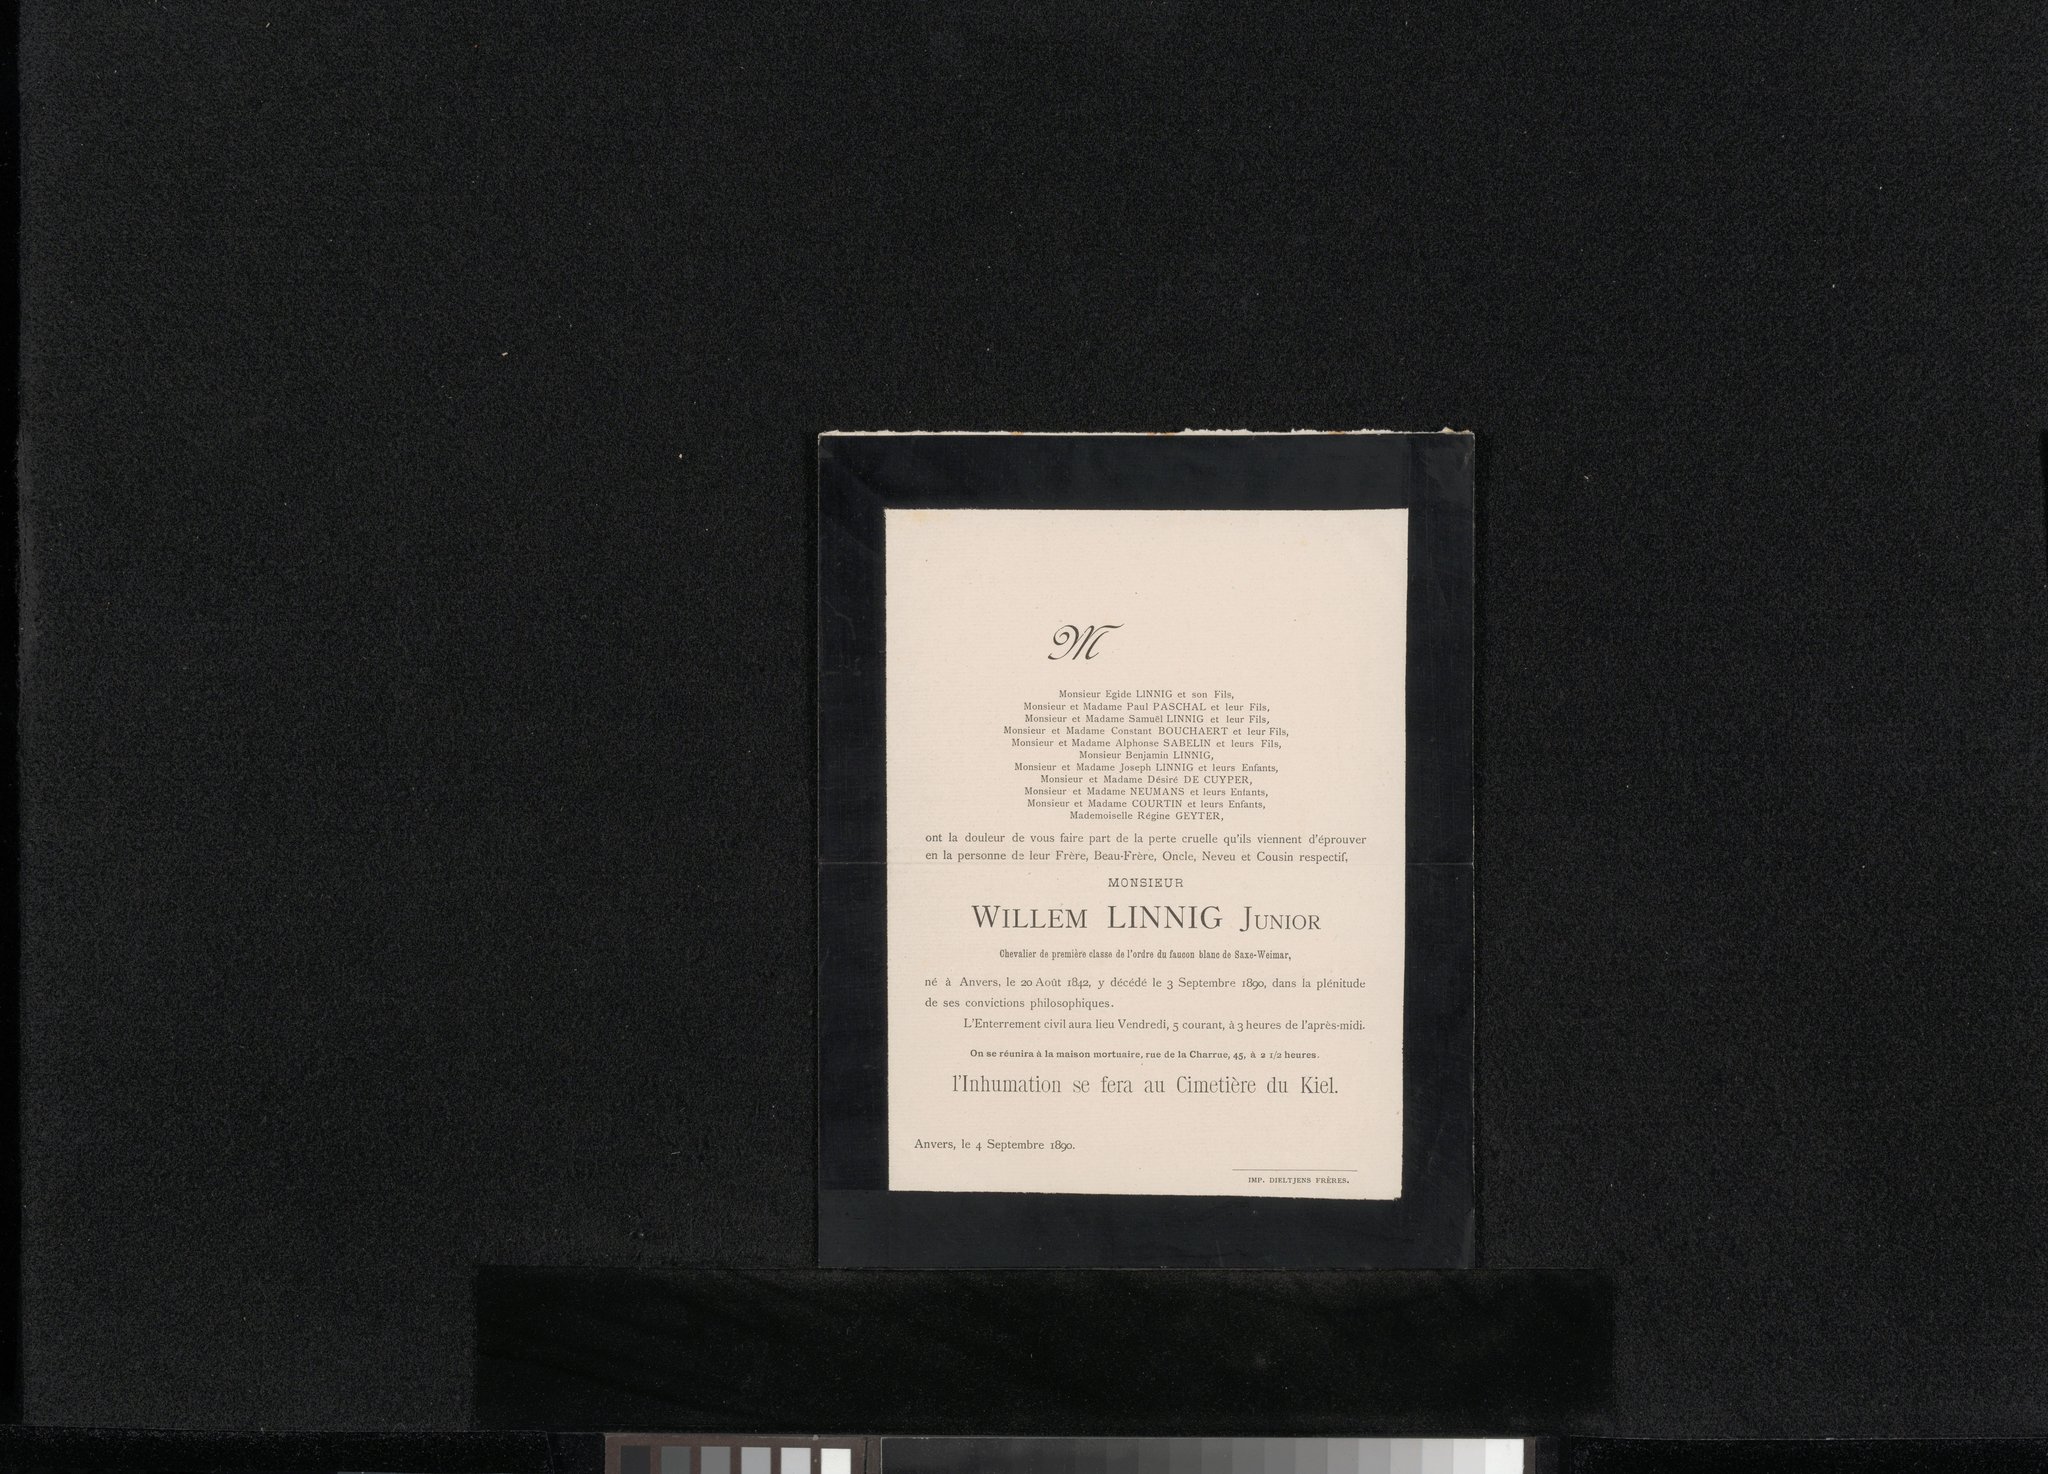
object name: overlijdensbericht, overlijdensadvertentie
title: Overlijdensbericht aan Johan Philip van der Kellen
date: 1890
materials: ink, paper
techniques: pen, printing, writing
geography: antwerp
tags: utrecht, draughtsman, johan philip van der kellen, antwerp, print maker, willem linnig (ii)